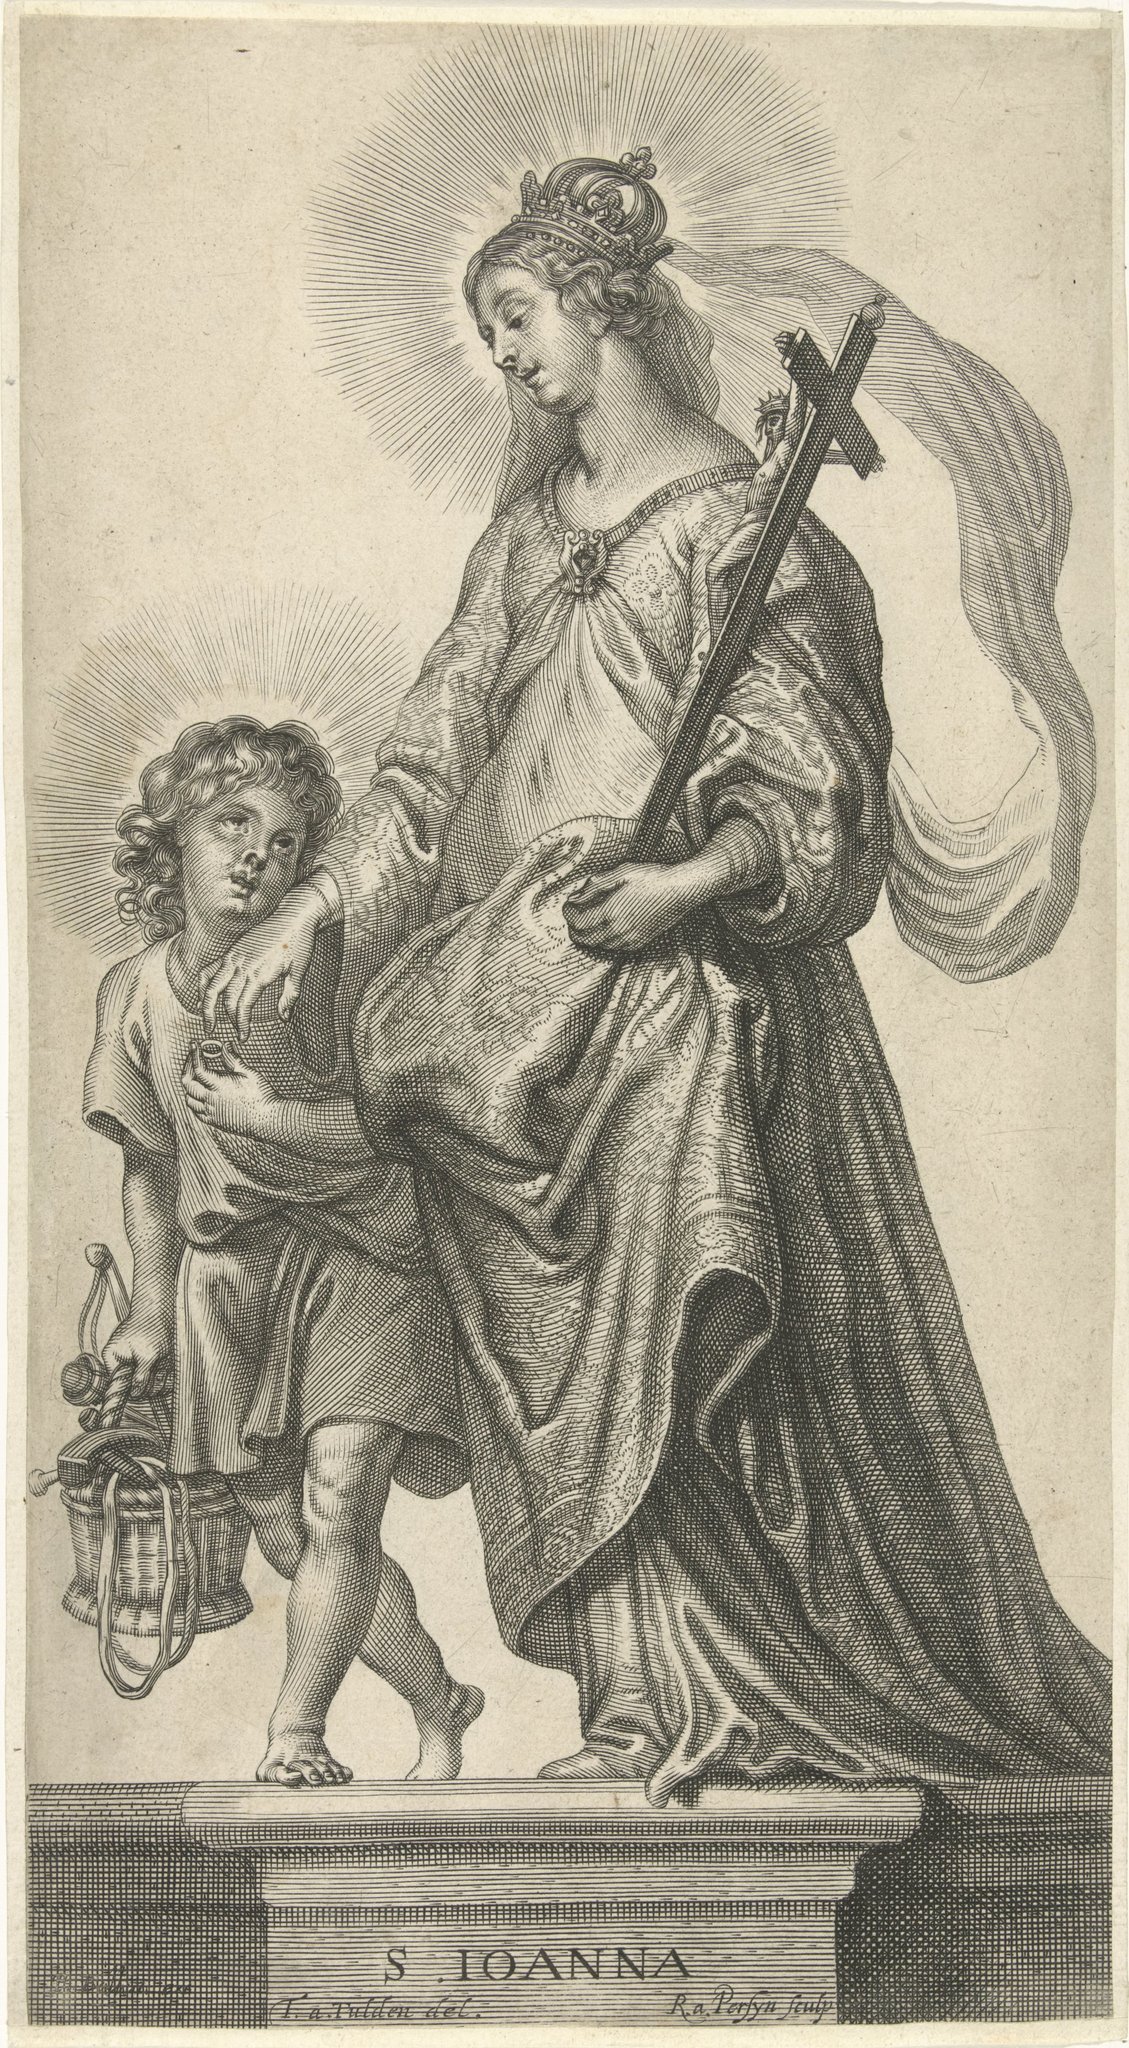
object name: print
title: H. Johanna van Valois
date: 1623-1668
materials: paper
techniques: engraving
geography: gouda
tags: christ-child carrying the instruments of the passion, female saints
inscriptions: collector's mark: Lugt 2228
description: De Heilige Johanna van Valois, gekroond en met een crucifix in de handen, ontvangt een ring van het Christuskind, dat een mand met de passiewerktuigen vasthoudt.